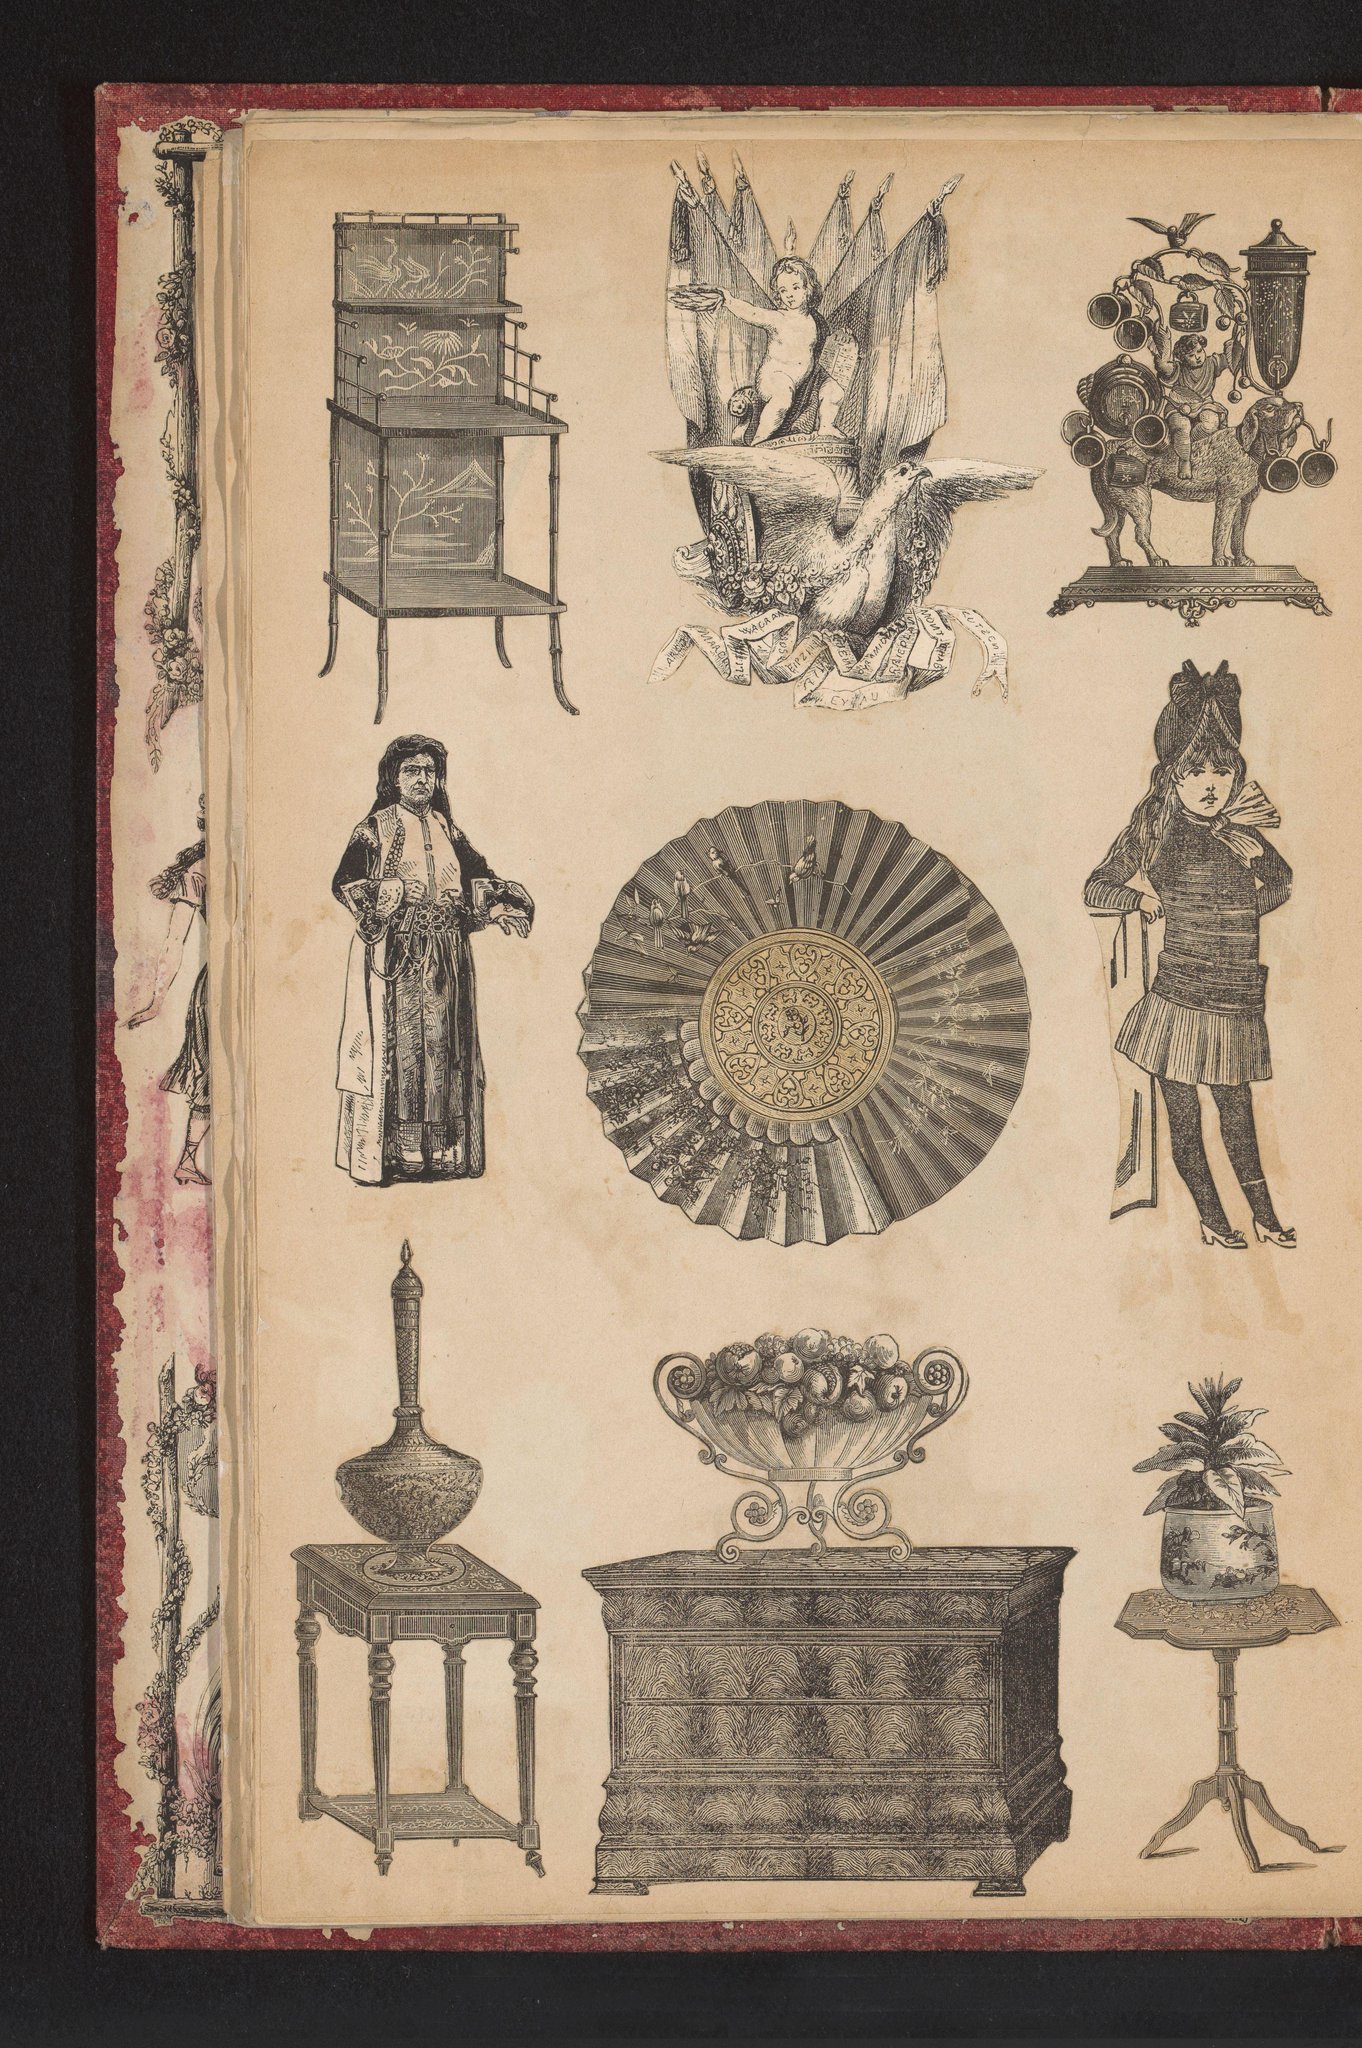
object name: print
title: Collage van uitgeknipte prenten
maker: Anonymous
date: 1870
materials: paper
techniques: engraving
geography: paris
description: Collage van uitgeknipte prenten. Onderdeel van een album met 32 bladen, aan beide zijden beplakt met uitgeknipte prenten, vermoedelijk afkomstig uit 19e-eeuwse tijdschiften.